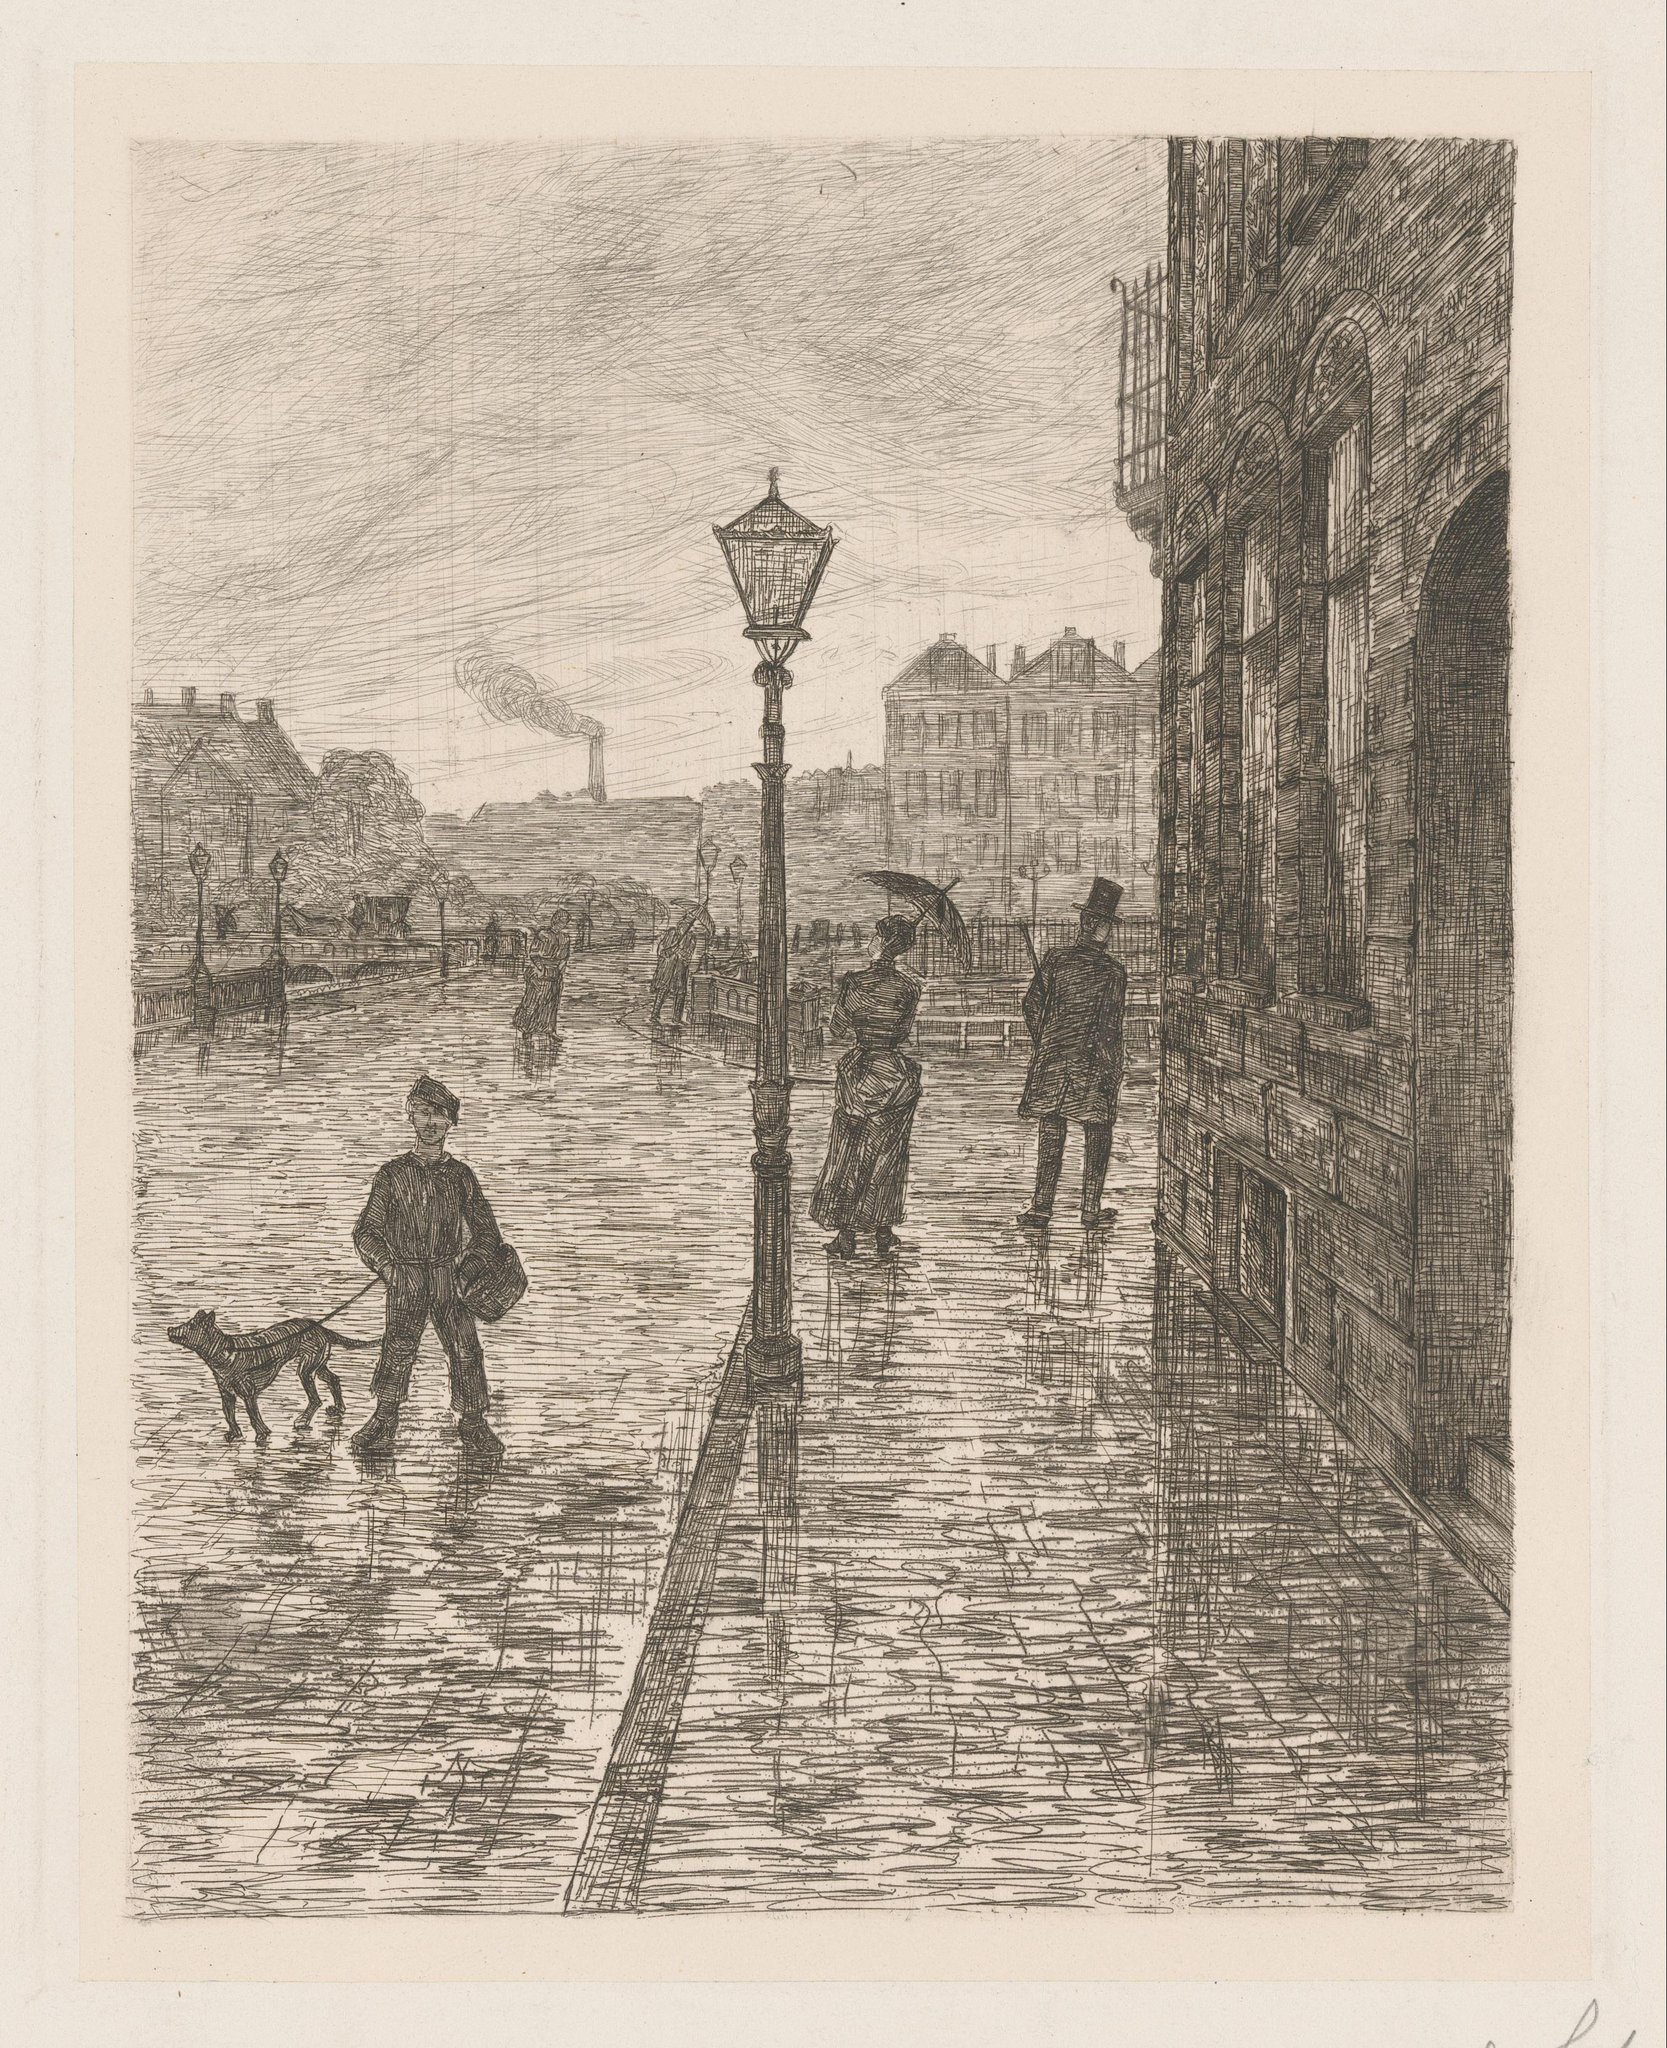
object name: print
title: Stadsgezicht bij regen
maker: egbert rubertus derk schaap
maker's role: draughtsman, painter, print maker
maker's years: 1862-1939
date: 1877-1886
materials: paper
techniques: etching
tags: city-view, and landscape with man-made constructions, city dwellers, dog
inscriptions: collector's mark: Lugt 2228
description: Links op de voorgrond loopt een jongen met een hond. Rechts loopt een man met een hoed en links daarvan een vrouw met een paraplu.